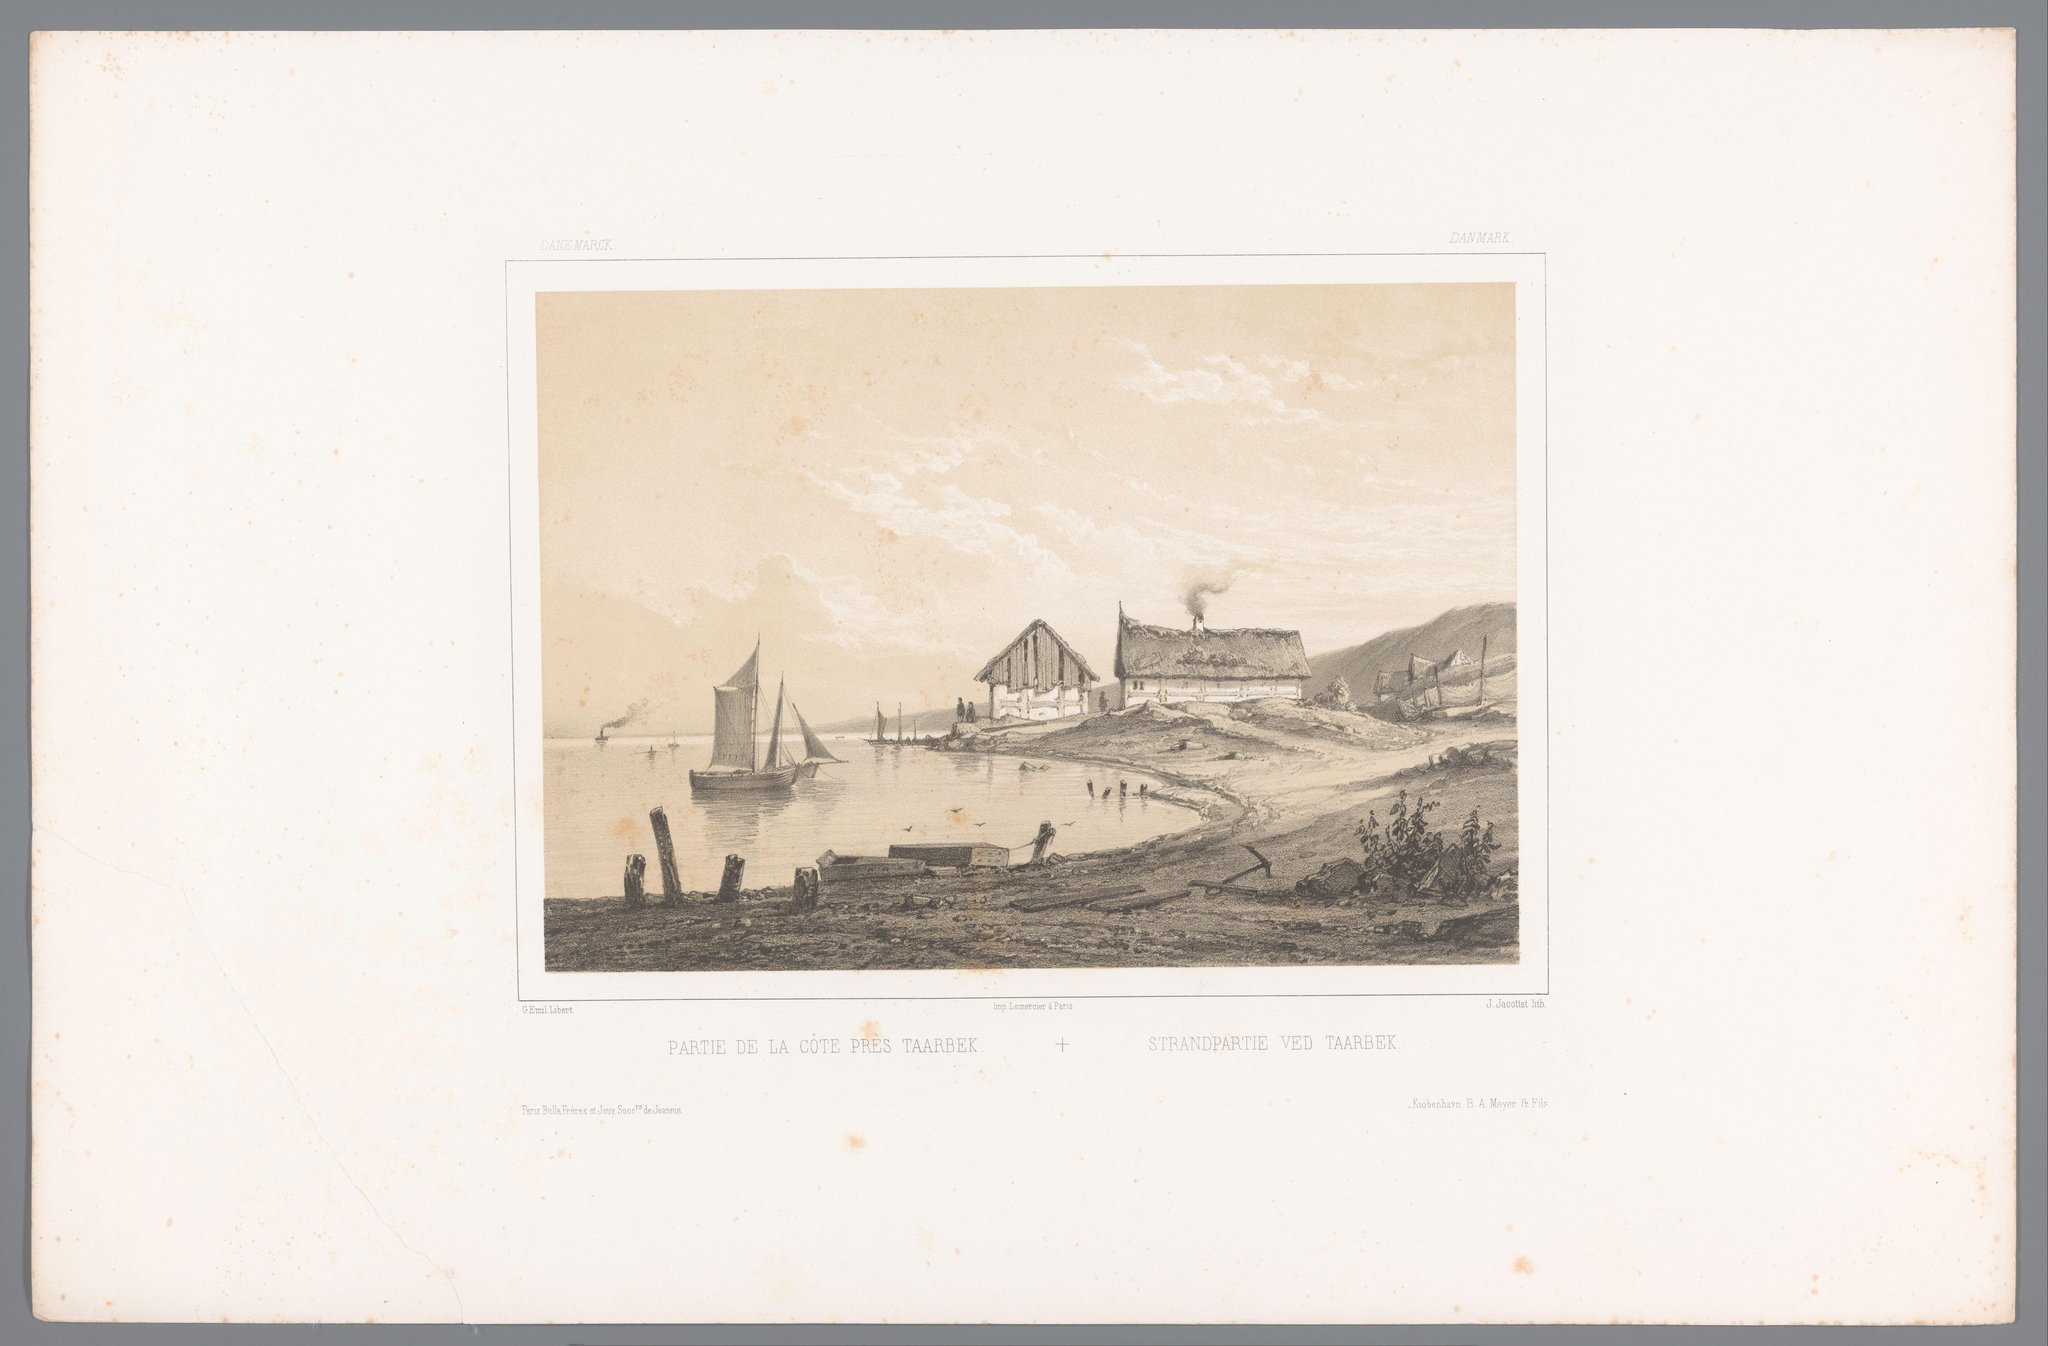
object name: print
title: Gezichten in Scandinavië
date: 1851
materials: paper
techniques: tone lithography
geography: paris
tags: gulf, bay (+ landscape with figures, staffage), beach (+ landscape with figures, staffage)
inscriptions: collector's mark: Lugt 2228a